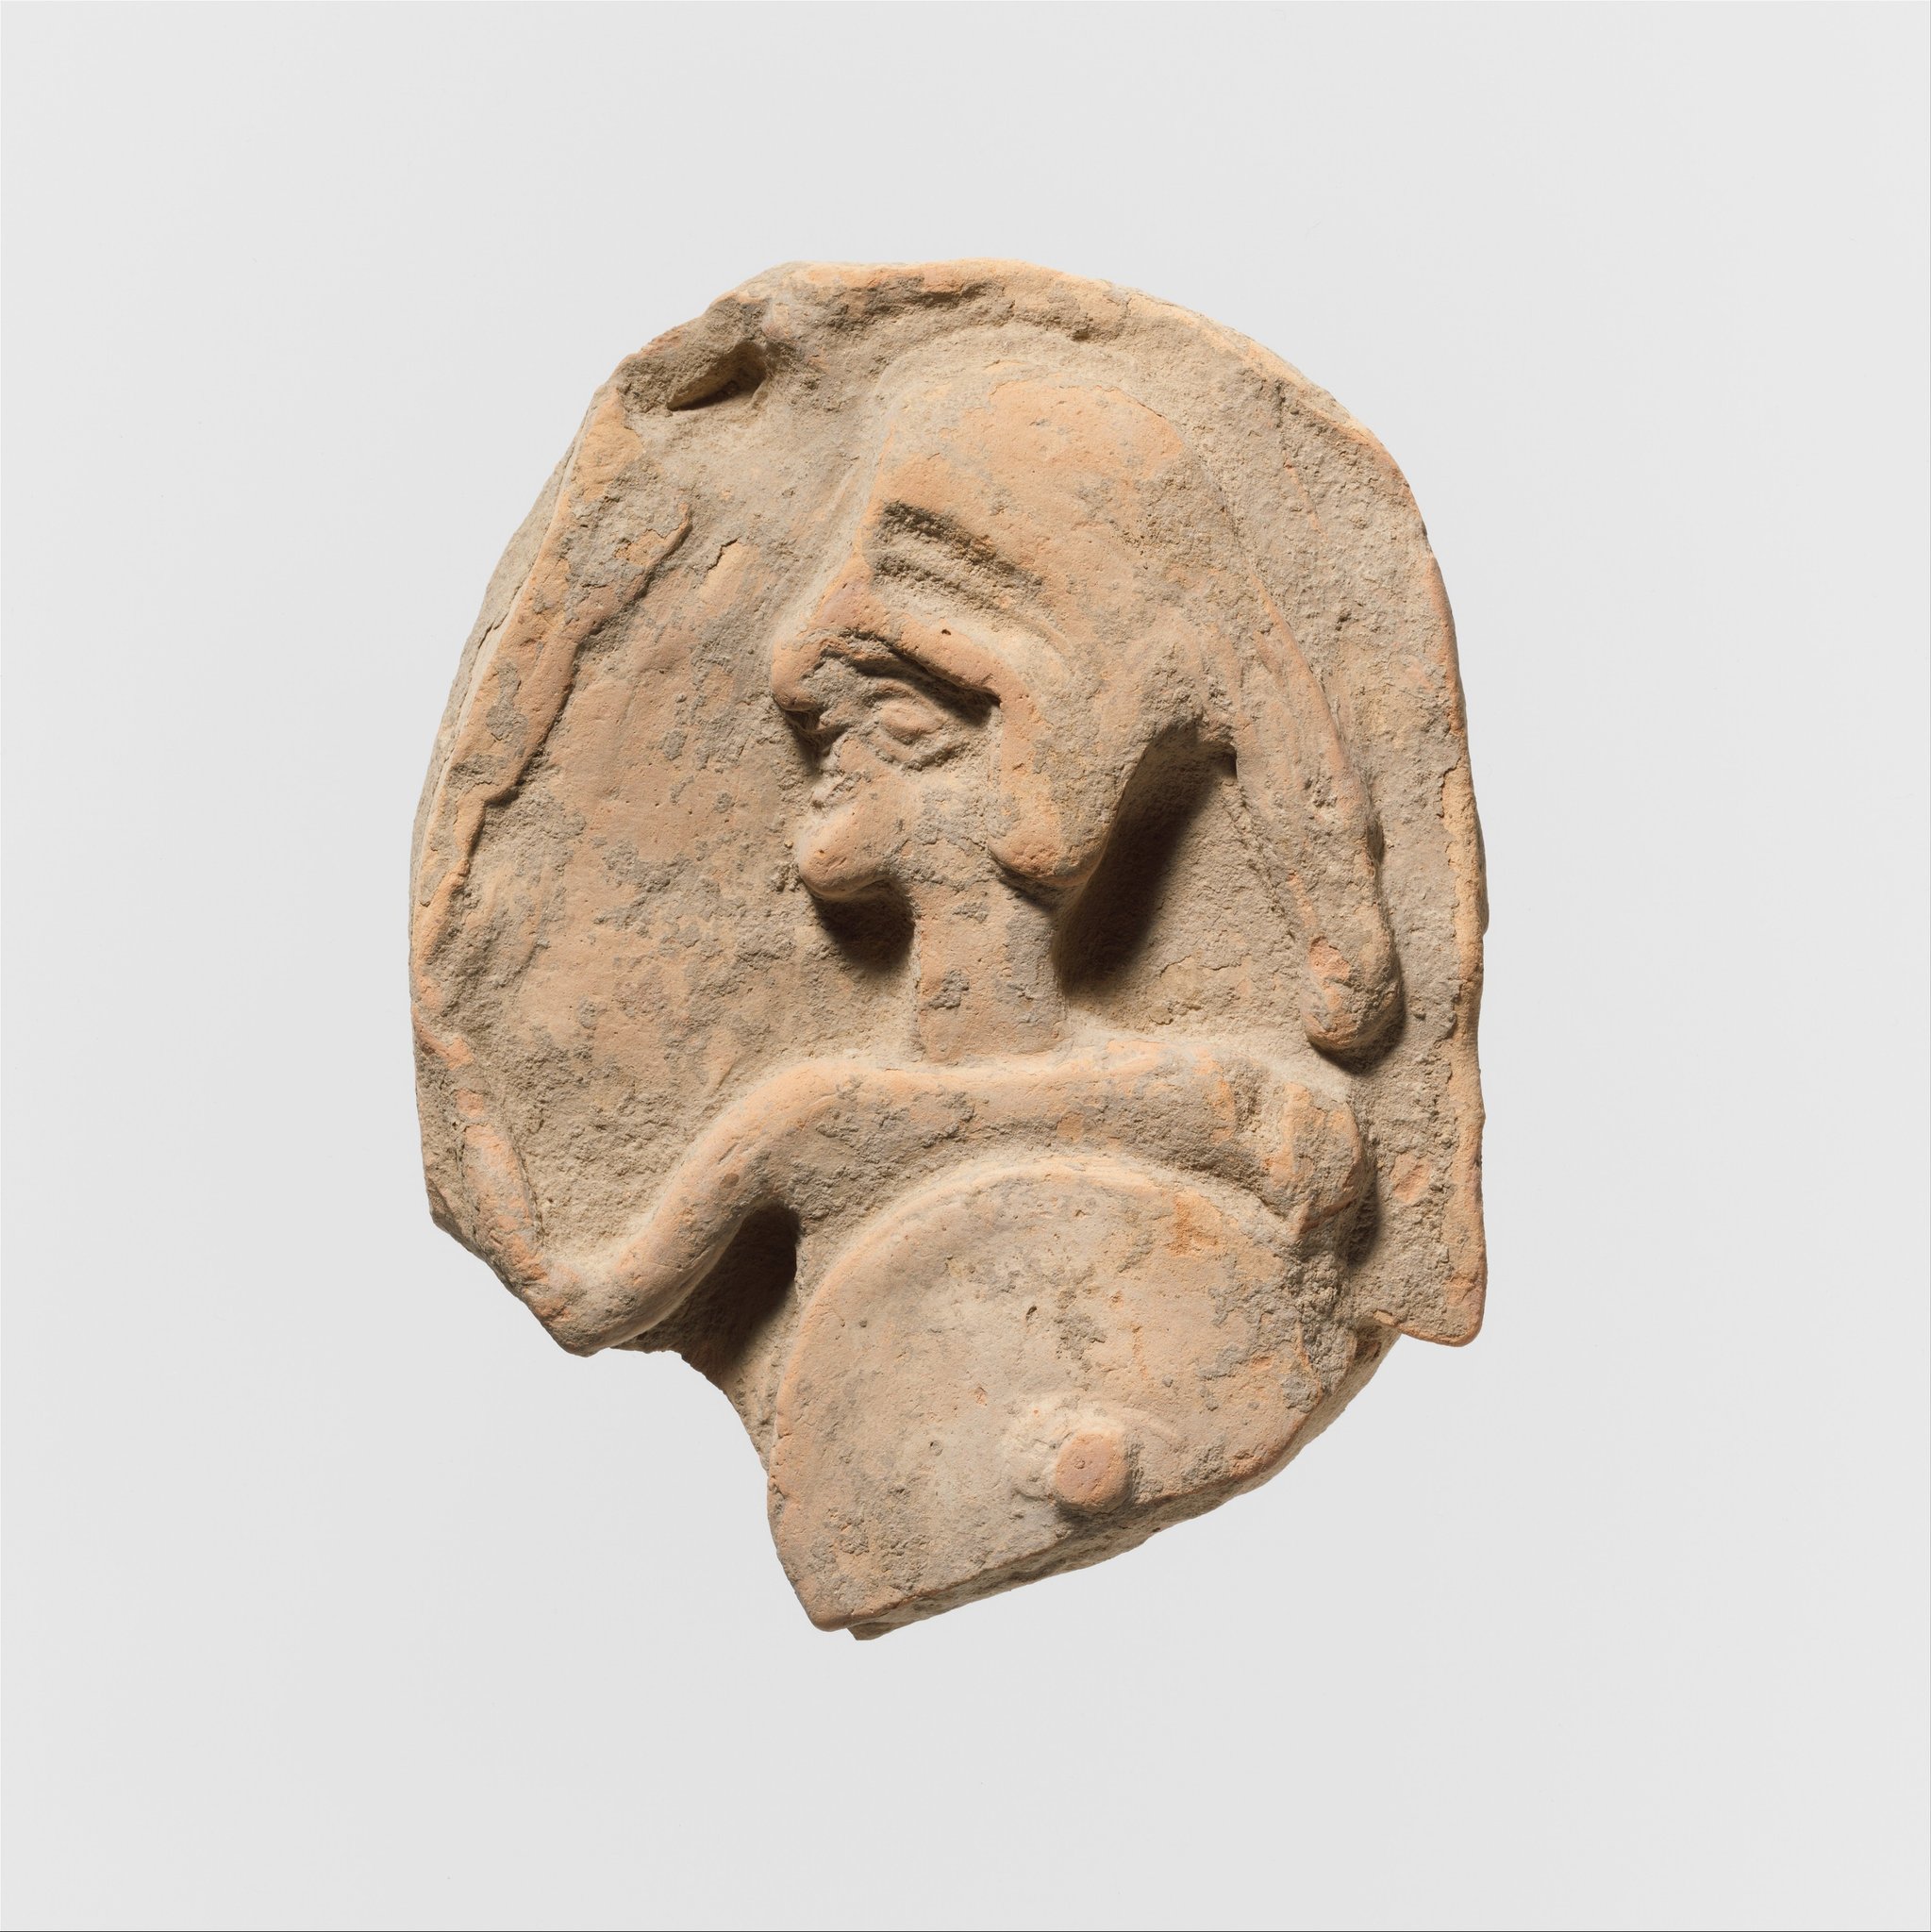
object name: pinax, warrior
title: Fragment of a terracotta plaque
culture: greek, cretan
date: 700-601 BCE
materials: terracotta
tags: soldiers,helmets,shields